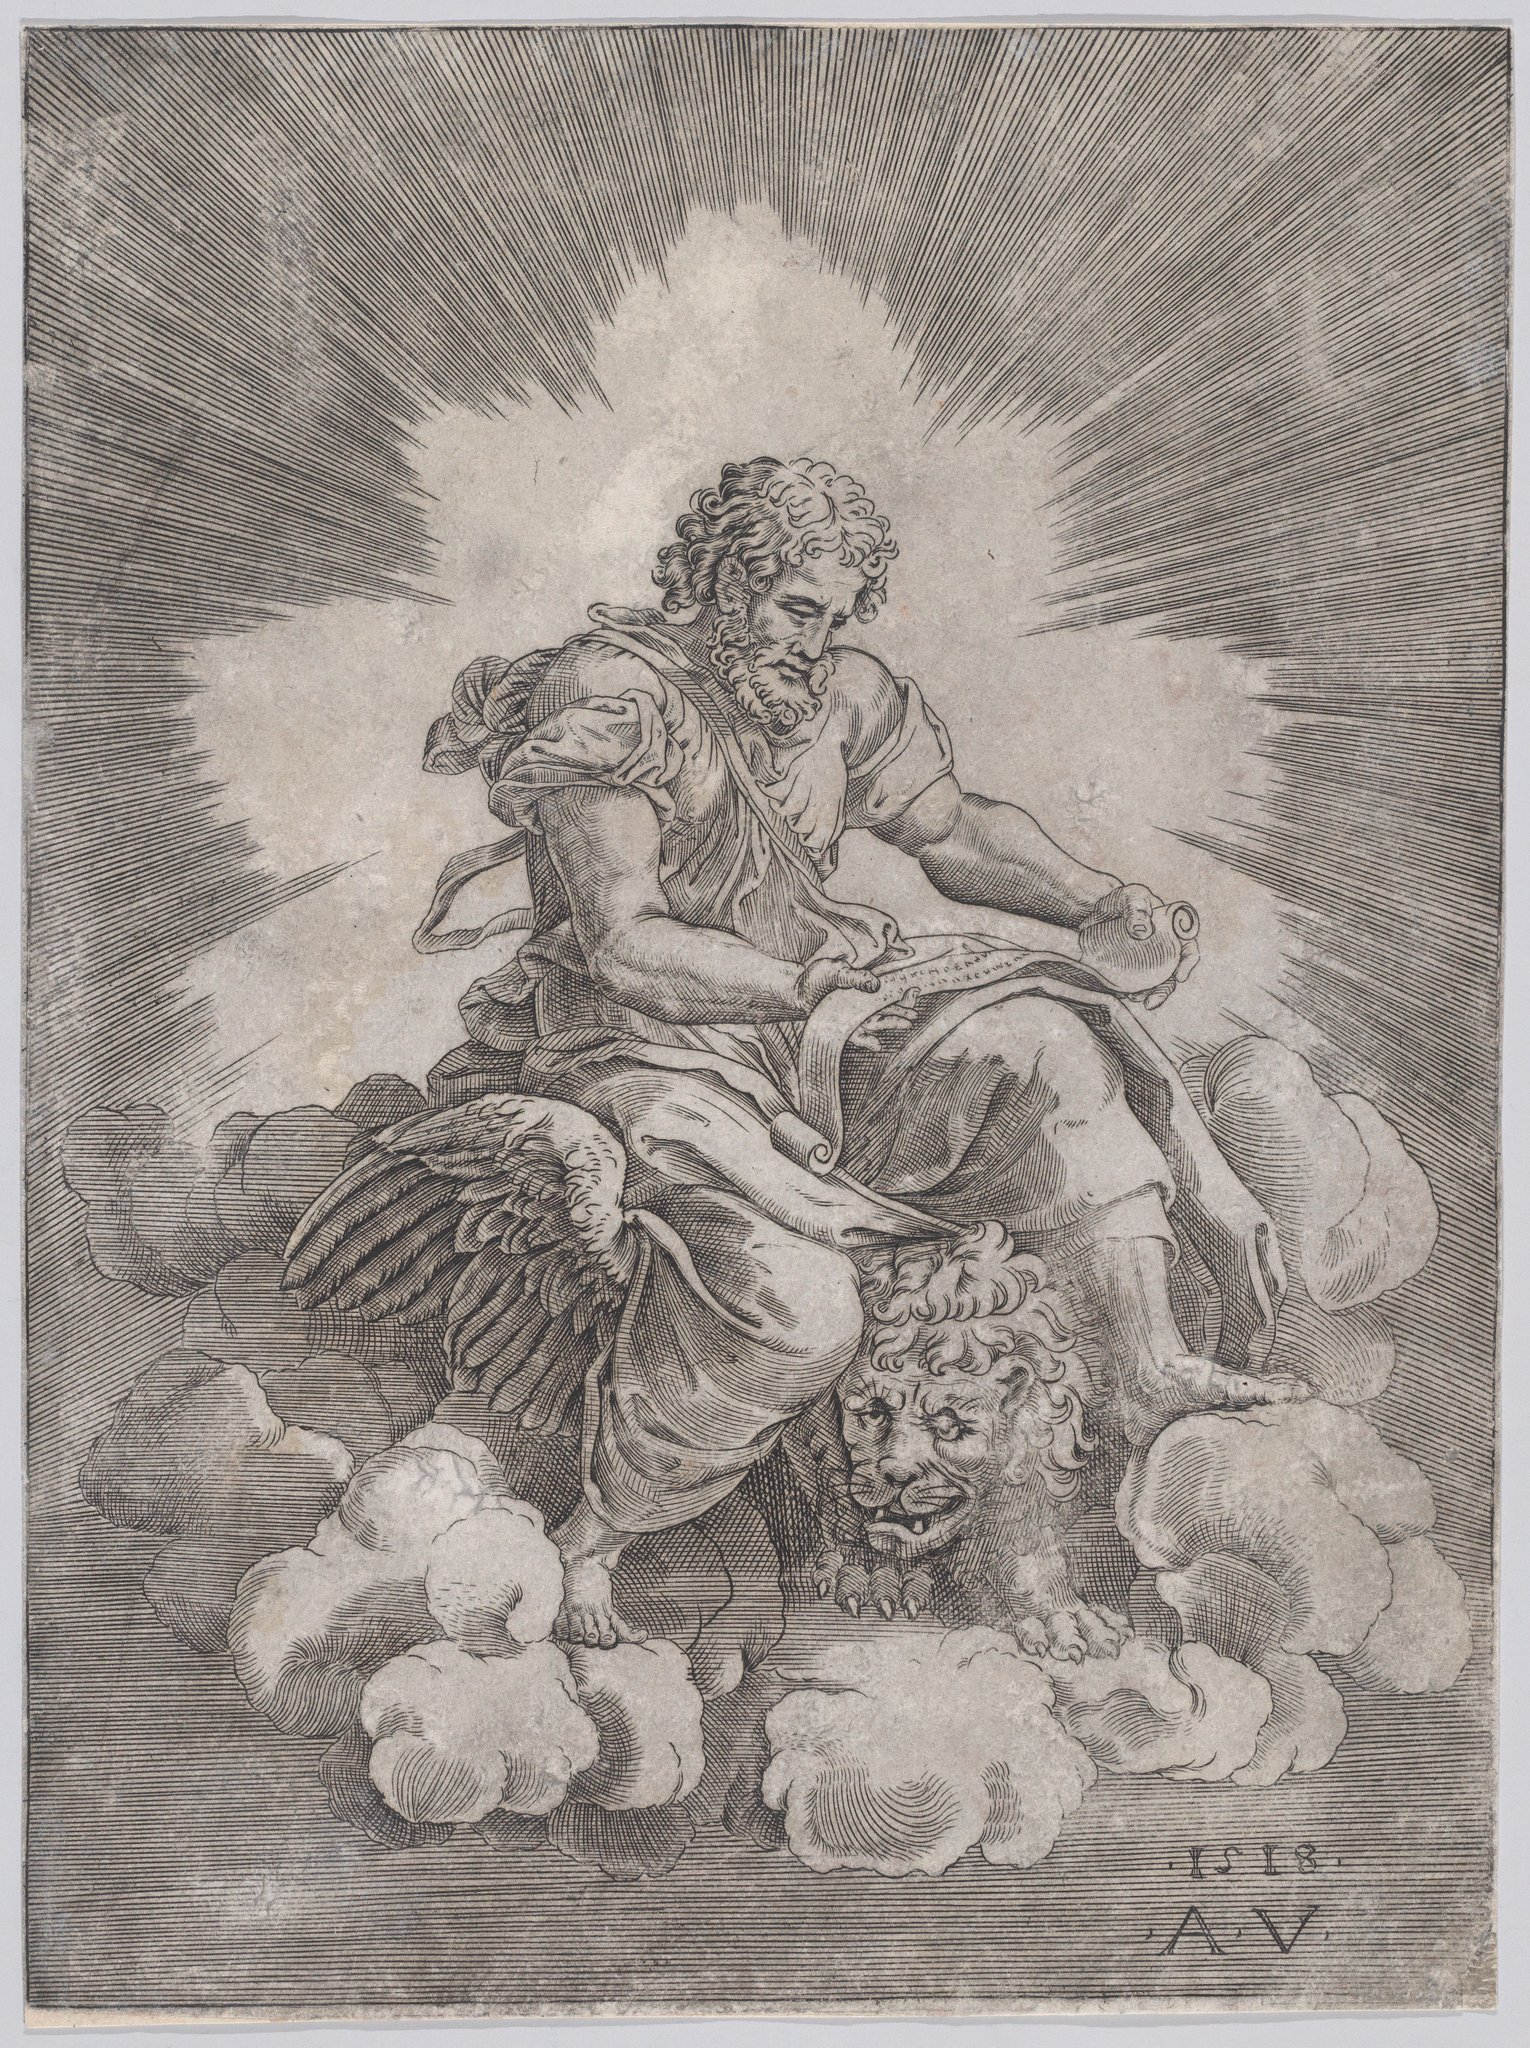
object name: print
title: Saint Mark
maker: agostino veneziano (agostino dei musi)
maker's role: artist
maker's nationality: italian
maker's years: 1490-1536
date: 1518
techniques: engraving